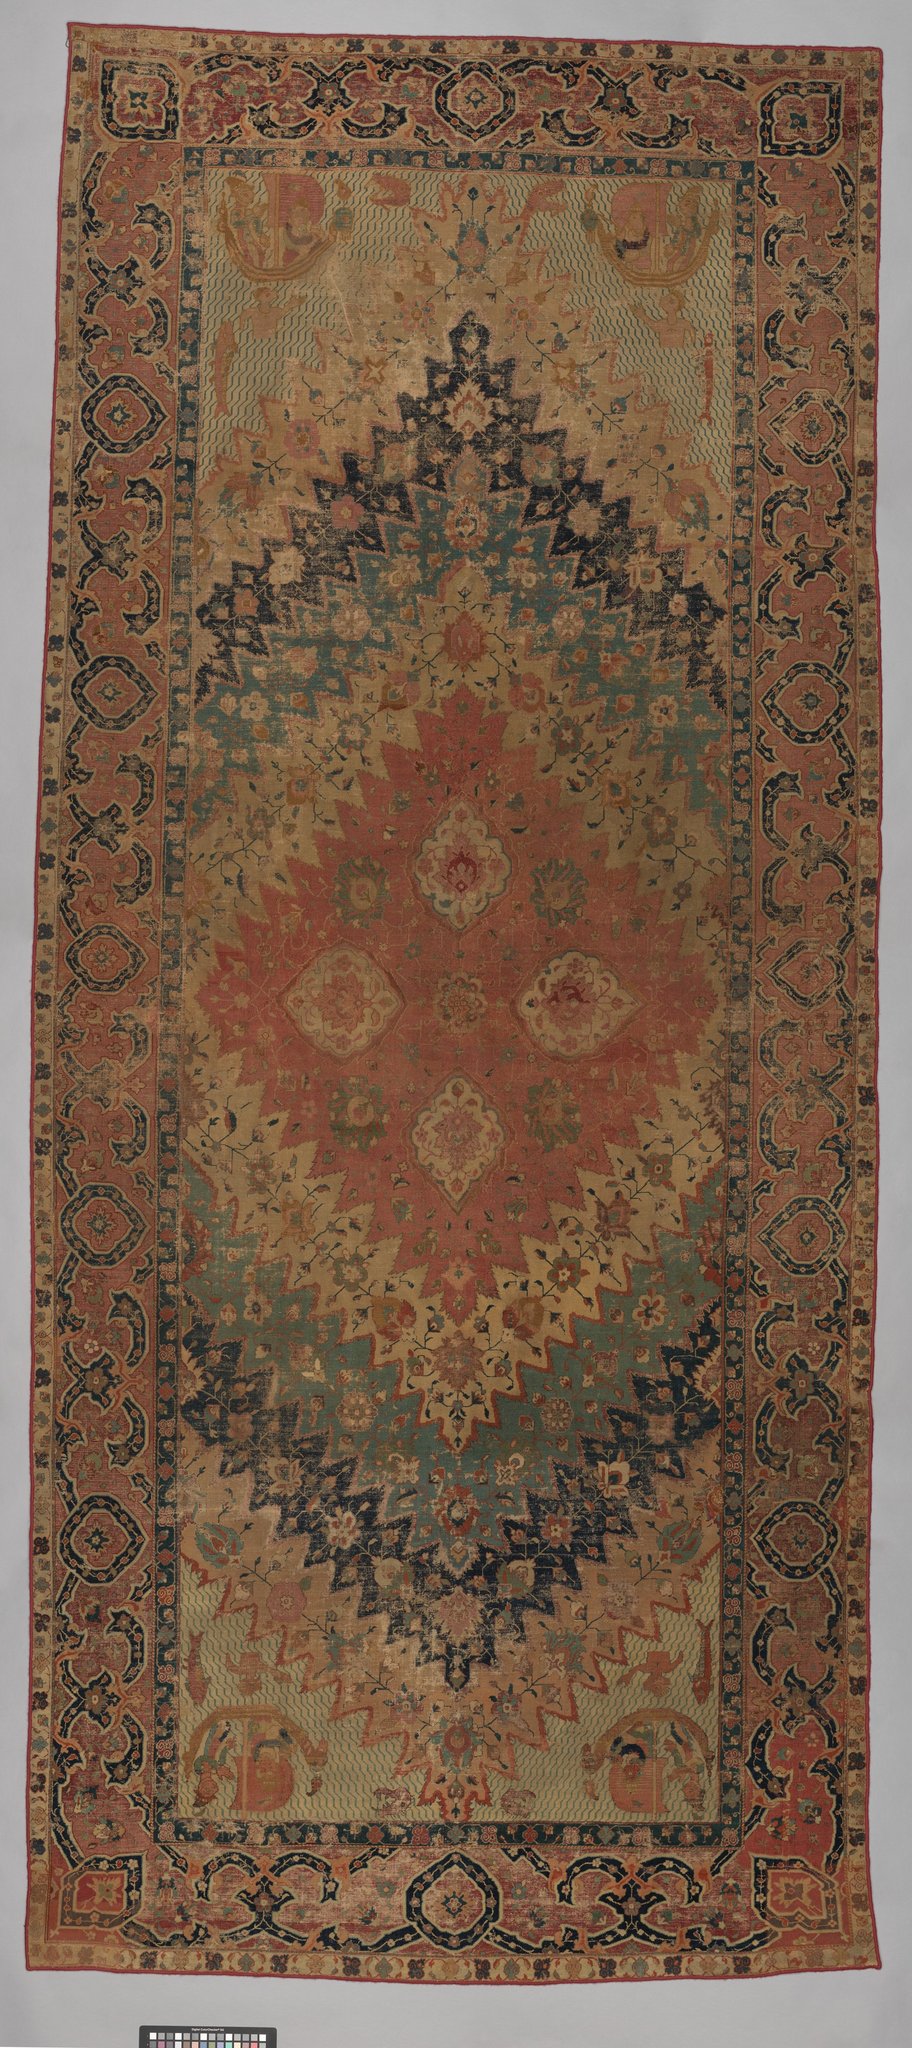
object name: carpet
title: "Portuguese" Carpet with Maritime Scenes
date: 1601-1700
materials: cotton, wool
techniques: asymmetrically knotted pile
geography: iran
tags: fish,flowers,ships